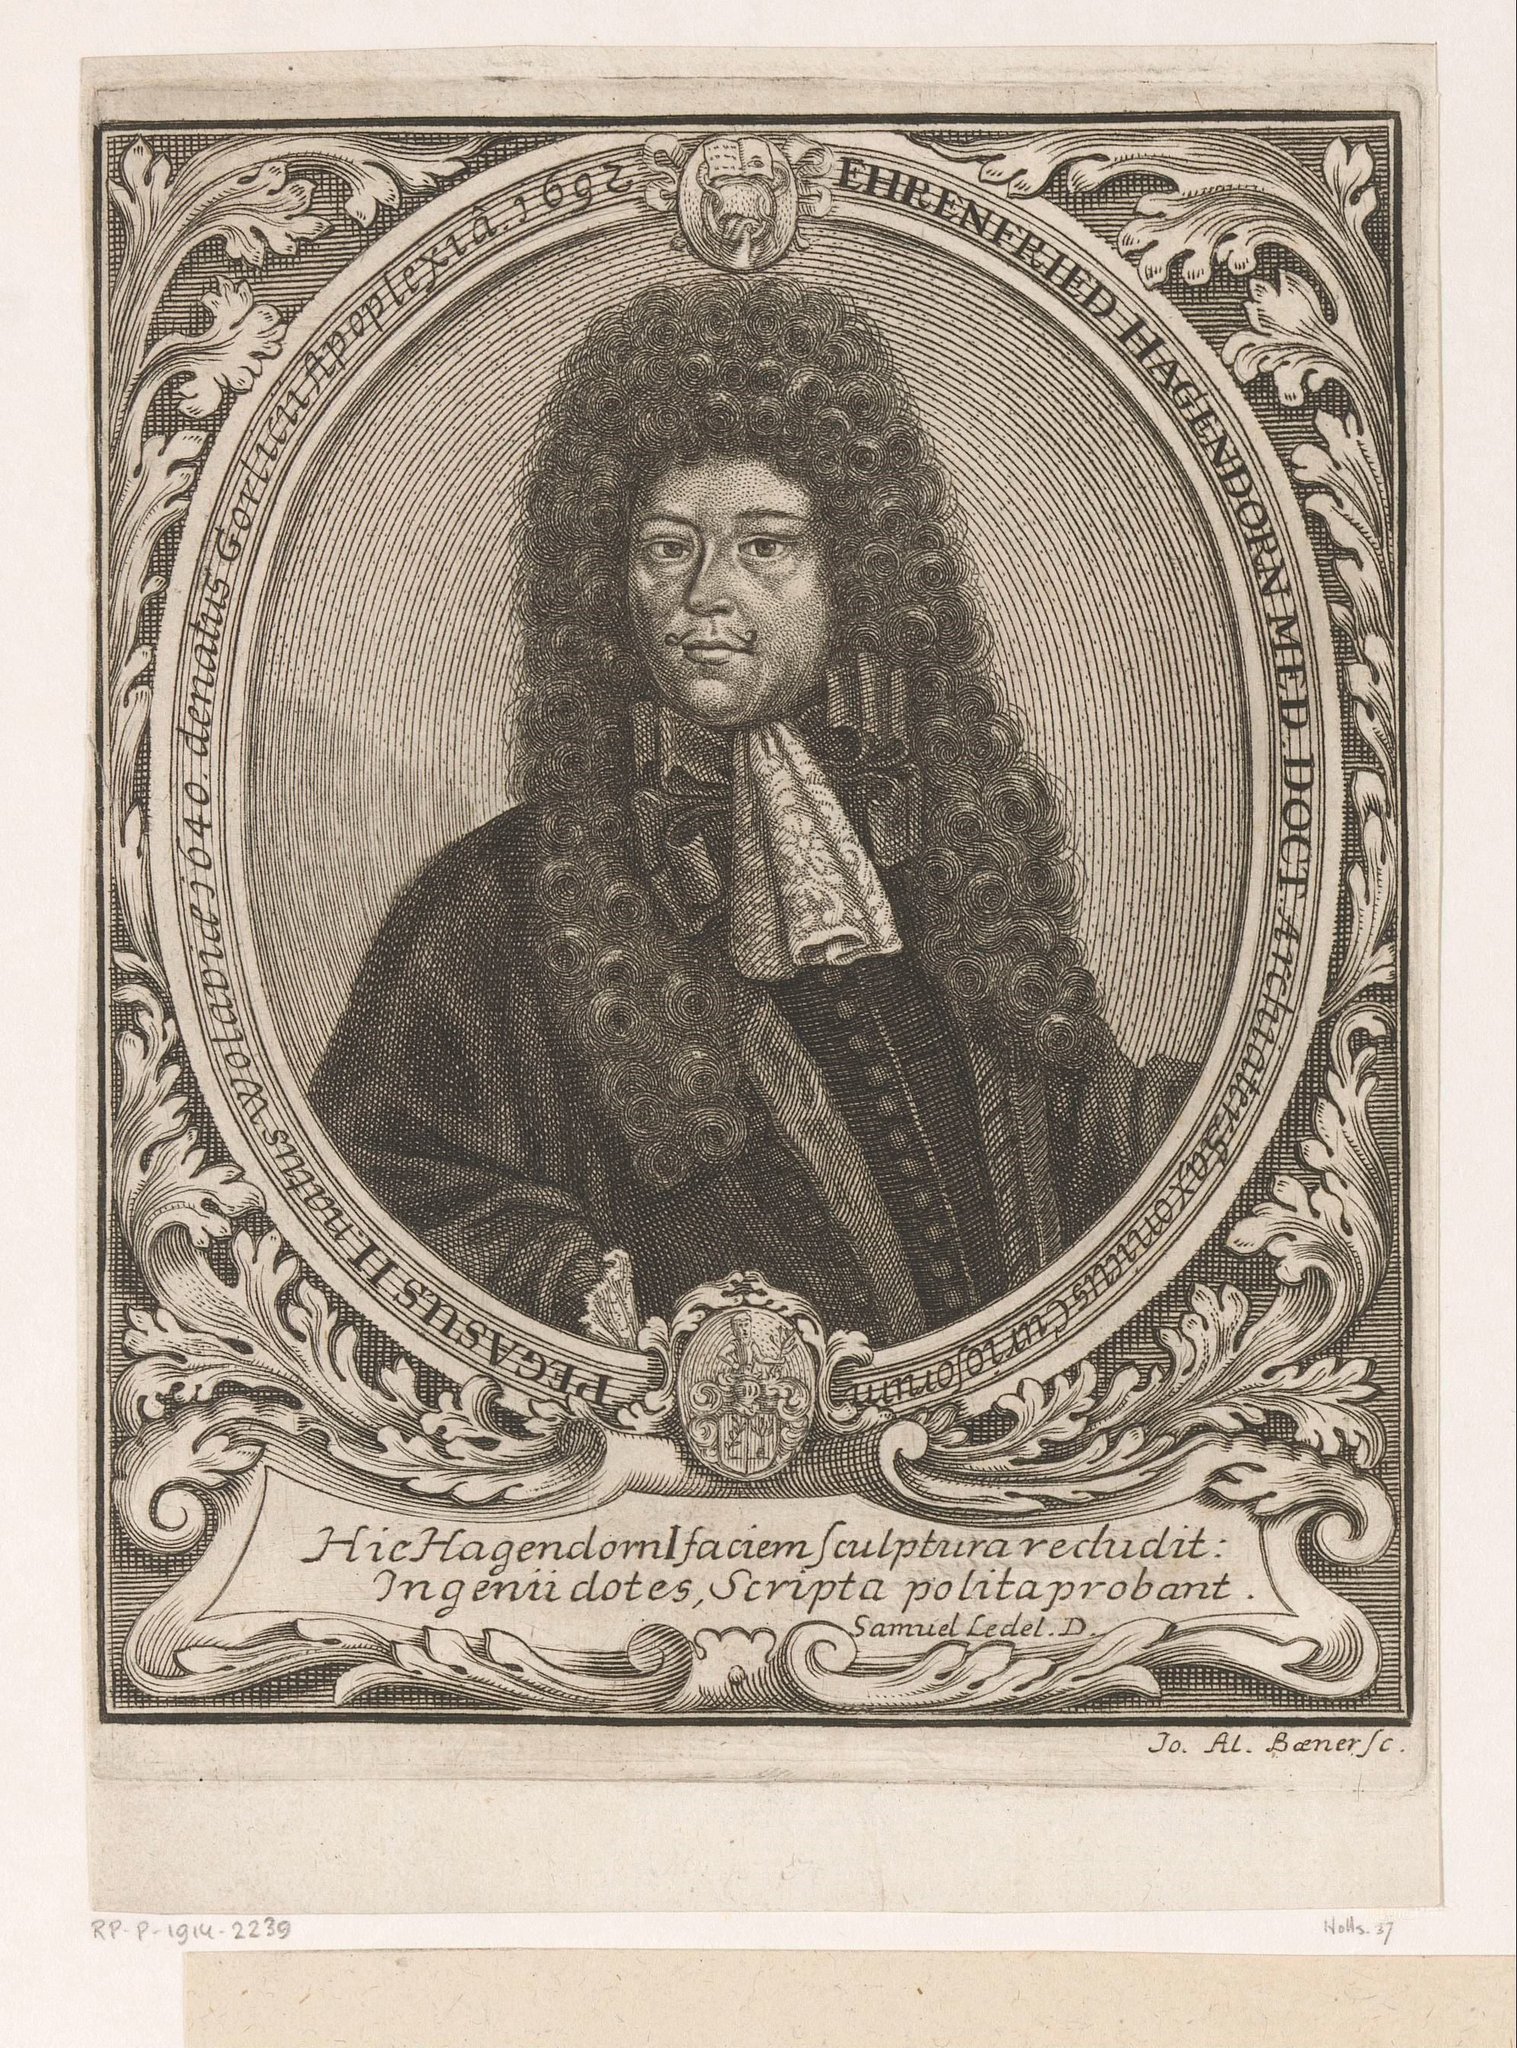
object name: print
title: Portret van Ehrenfried Hagendorn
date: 1692-1720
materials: paper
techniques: engraving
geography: nuremberg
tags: historical persons, armorial bearing, heraldry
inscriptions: collector's mark: Lugt 2228